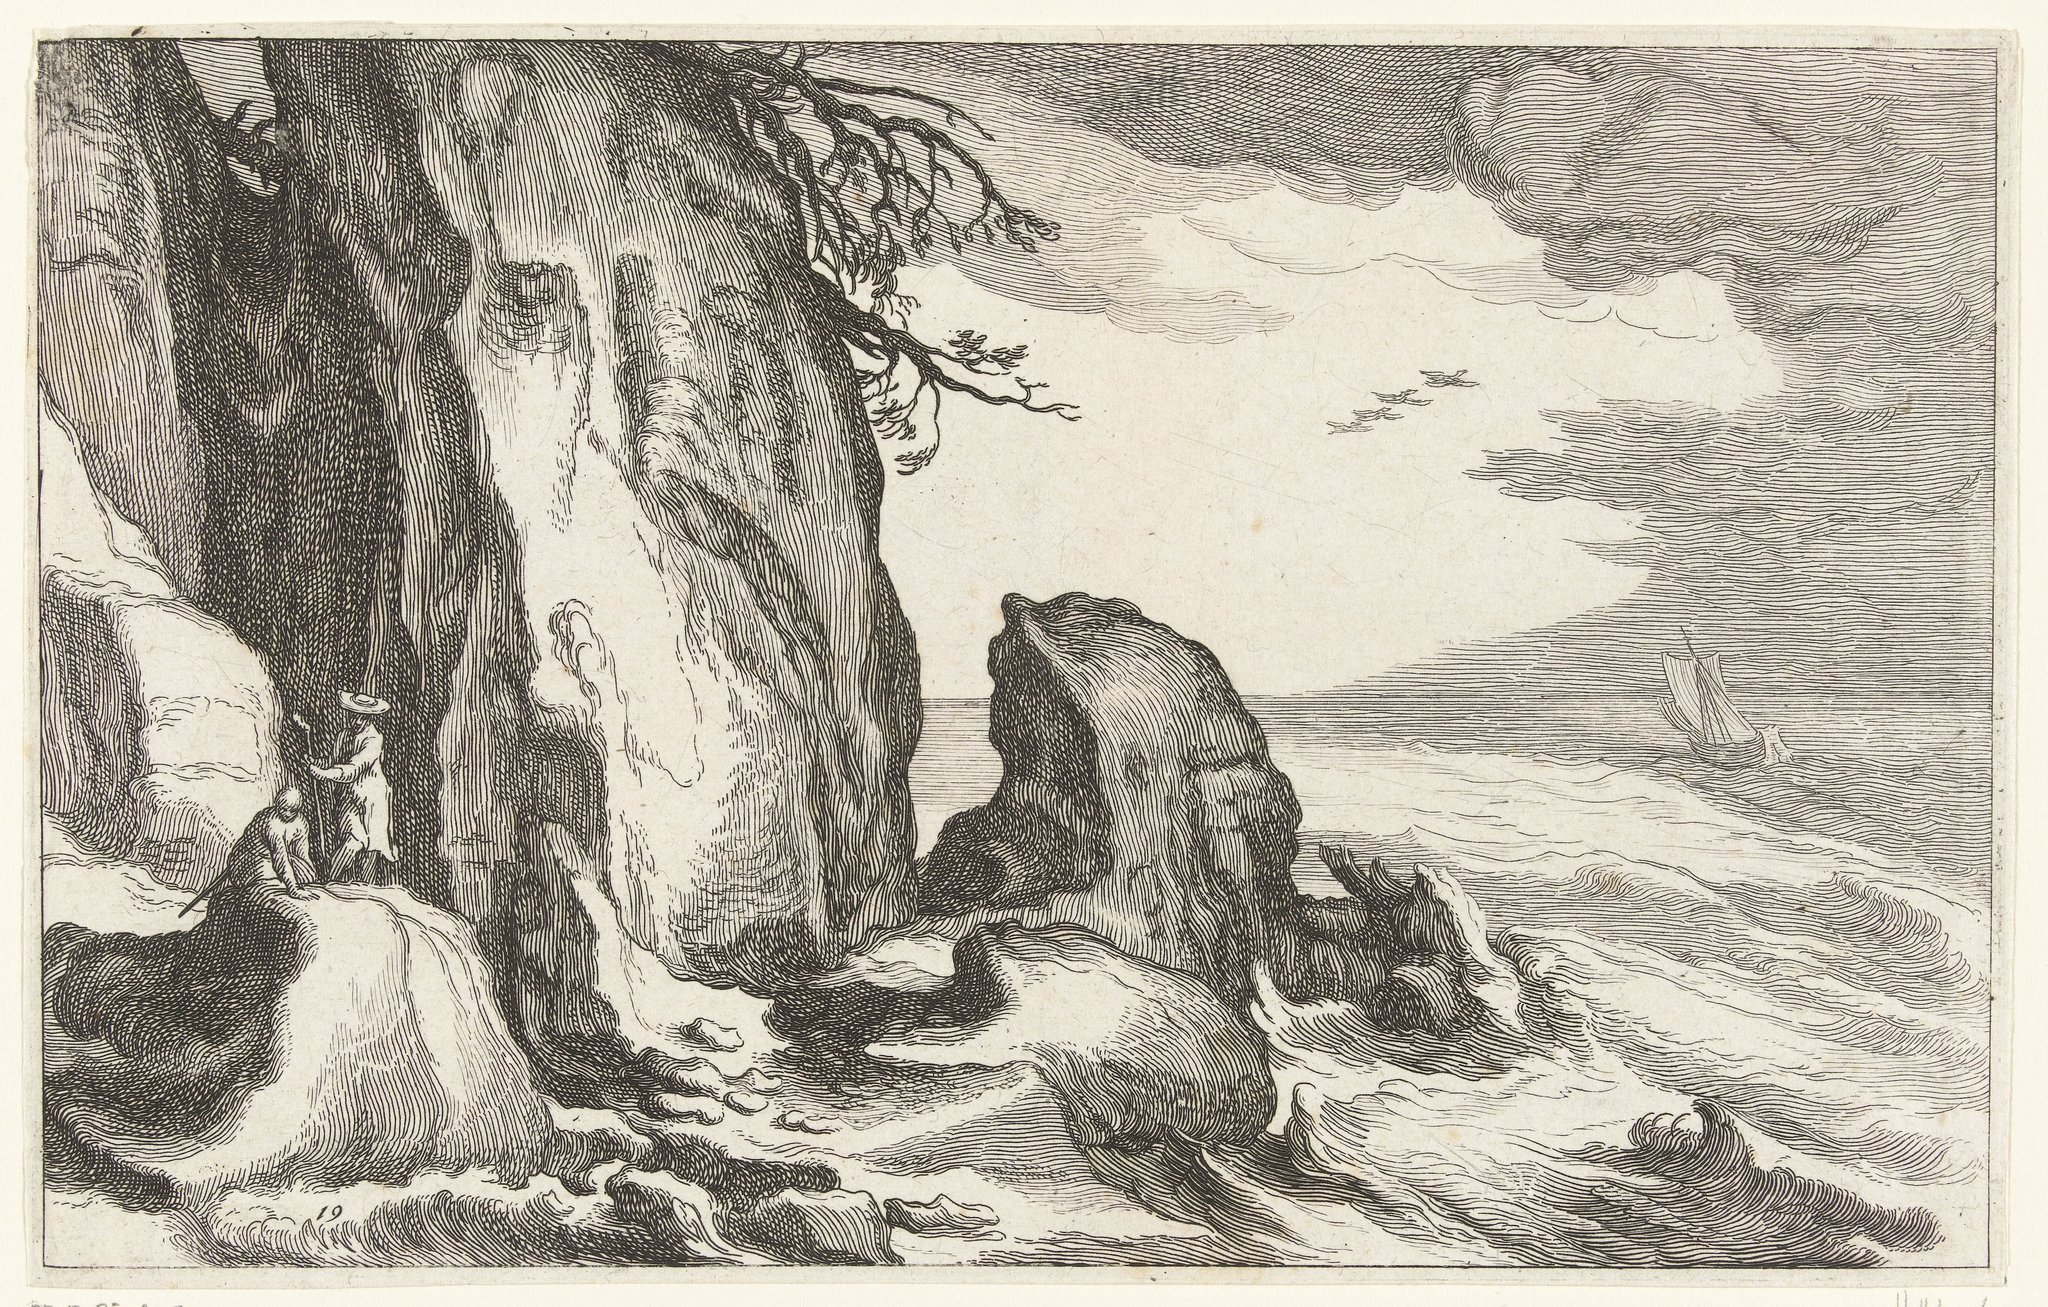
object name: print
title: Landschap met rotsen aan kust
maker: boëtius adamsz. bolswert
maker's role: print maker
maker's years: 1580-1633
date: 1614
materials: paper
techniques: etching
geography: amsterdam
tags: rocky coast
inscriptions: collector's mark: Lugt 240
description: Prent uit serie van twintig Landschappen met boerderijen naar ontwerp van Abraham Bloemaert.